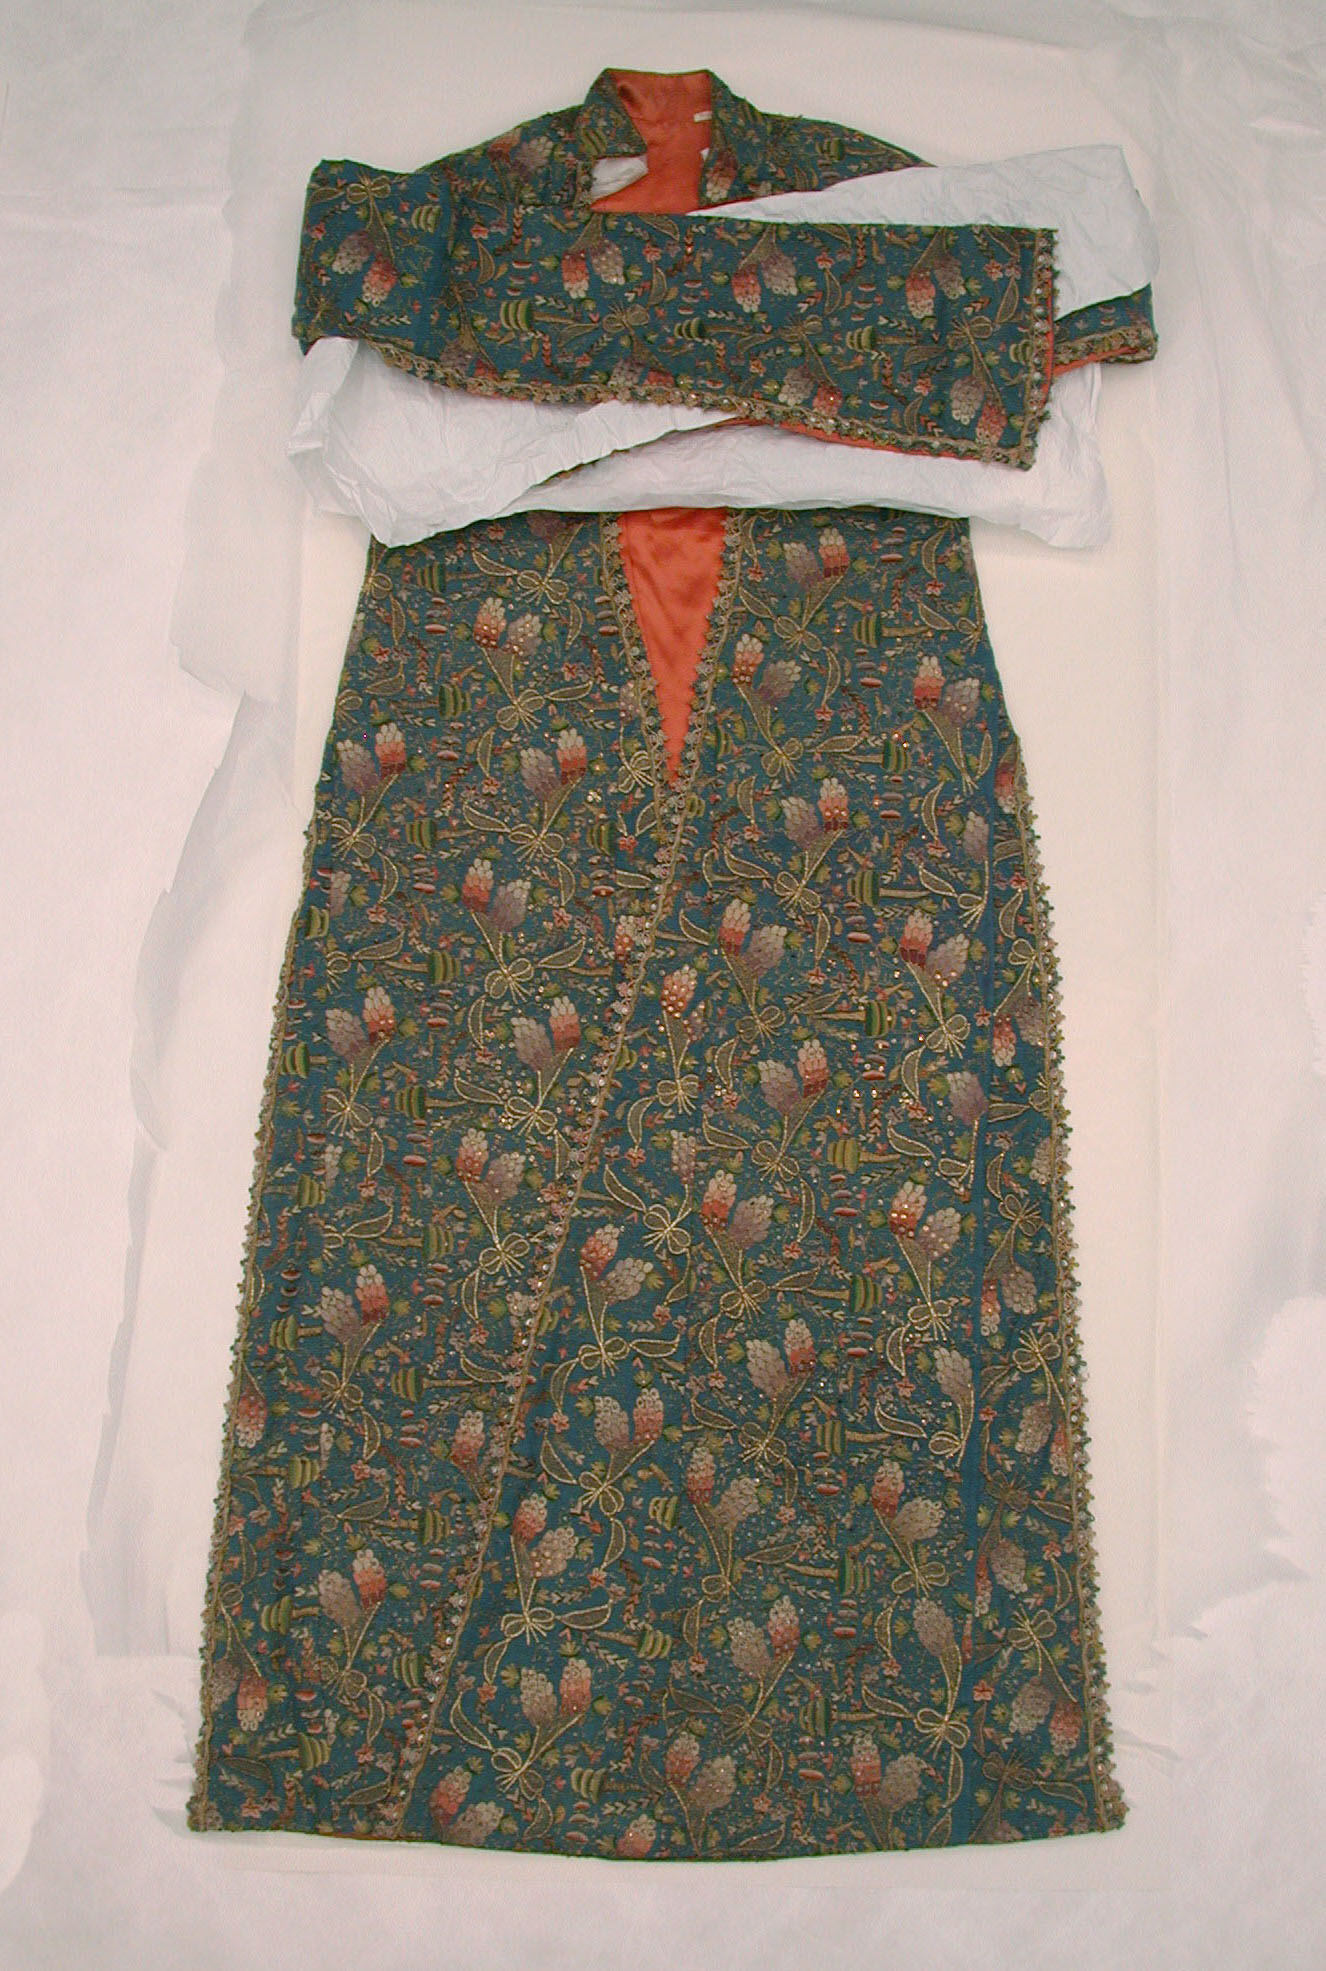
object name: robe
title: Entari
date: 1701-1800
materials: gilt, silk, thread, wool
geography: turkey